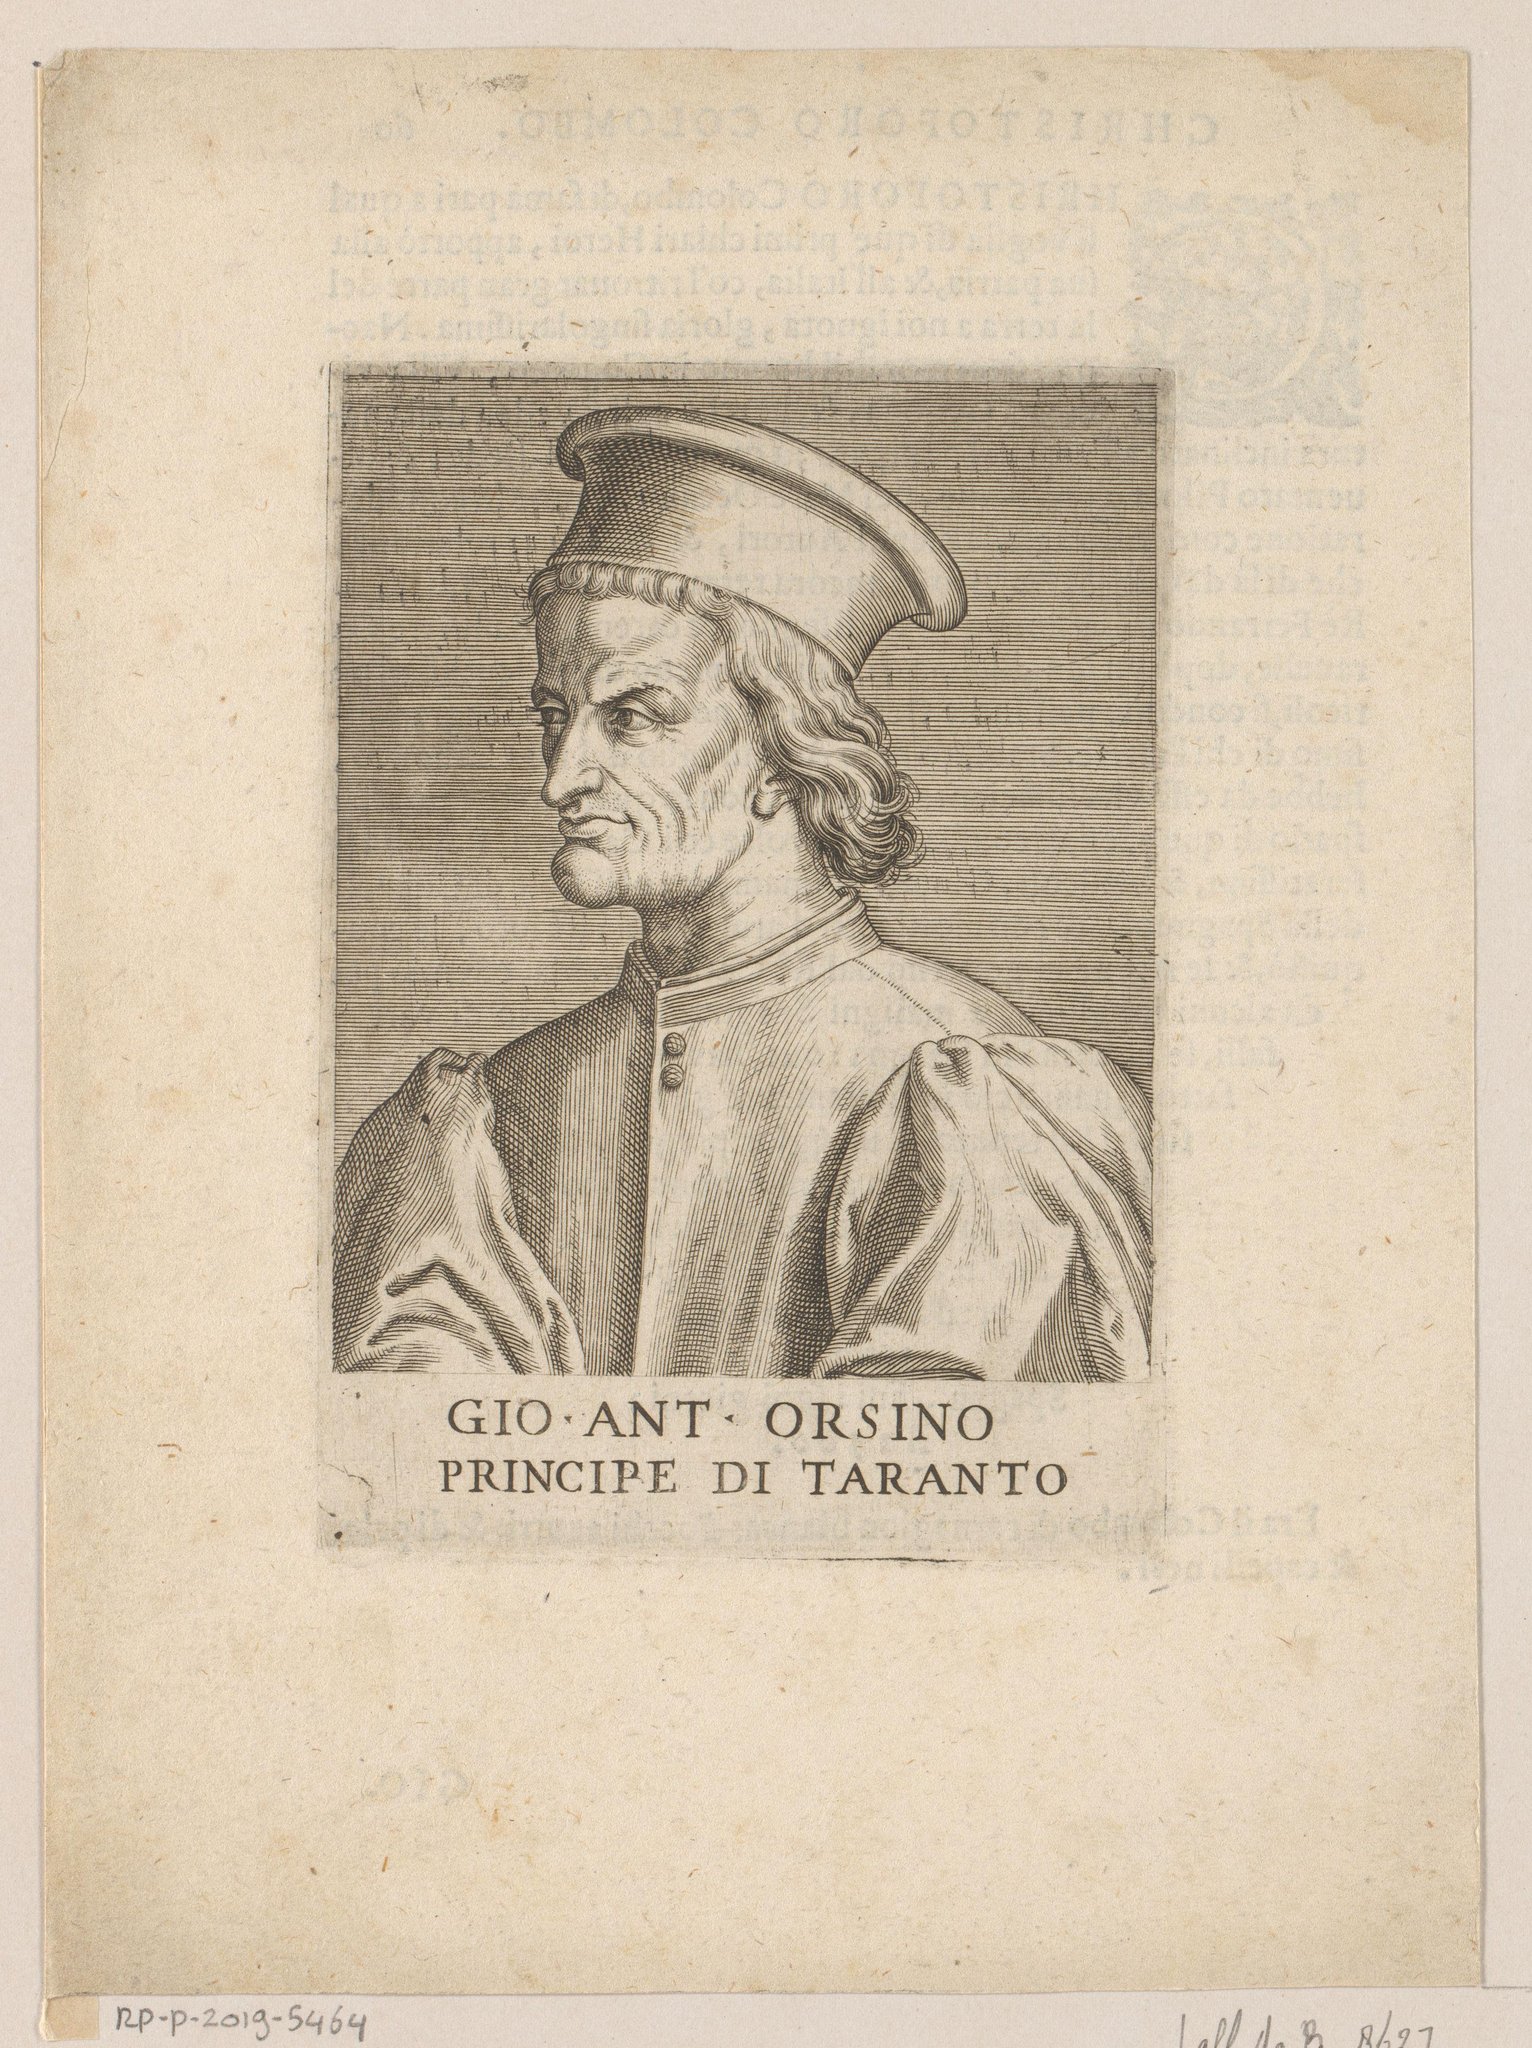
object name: print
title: Gio. Ant. Orsino principe di Taranto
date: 1596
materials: paper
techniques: engraving, letterpress printing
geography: rome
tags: lecce, altamura, commander-in-chief, general, marshal, historical persons, armorial bearing, heraldry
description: Prent uit: Ritratti di cento capitani illustri con li lor Fatti in guerra (…), Rome: Domenico Gigliotti, 1596, p. 60v. Latere staten van prent in ieder geval ook gebruikt in: Ritratti et elogii di capitani Illustri. Rome: Pompilio Totti en Andrea Fei, 1635. En in: Ritratti et elogii di capitani Illustri. Che ne'secoli moderni hanno gloriosamente guerreggiato. Rome: Filippo de'Rossi en Vitale Mascardi, 1646.